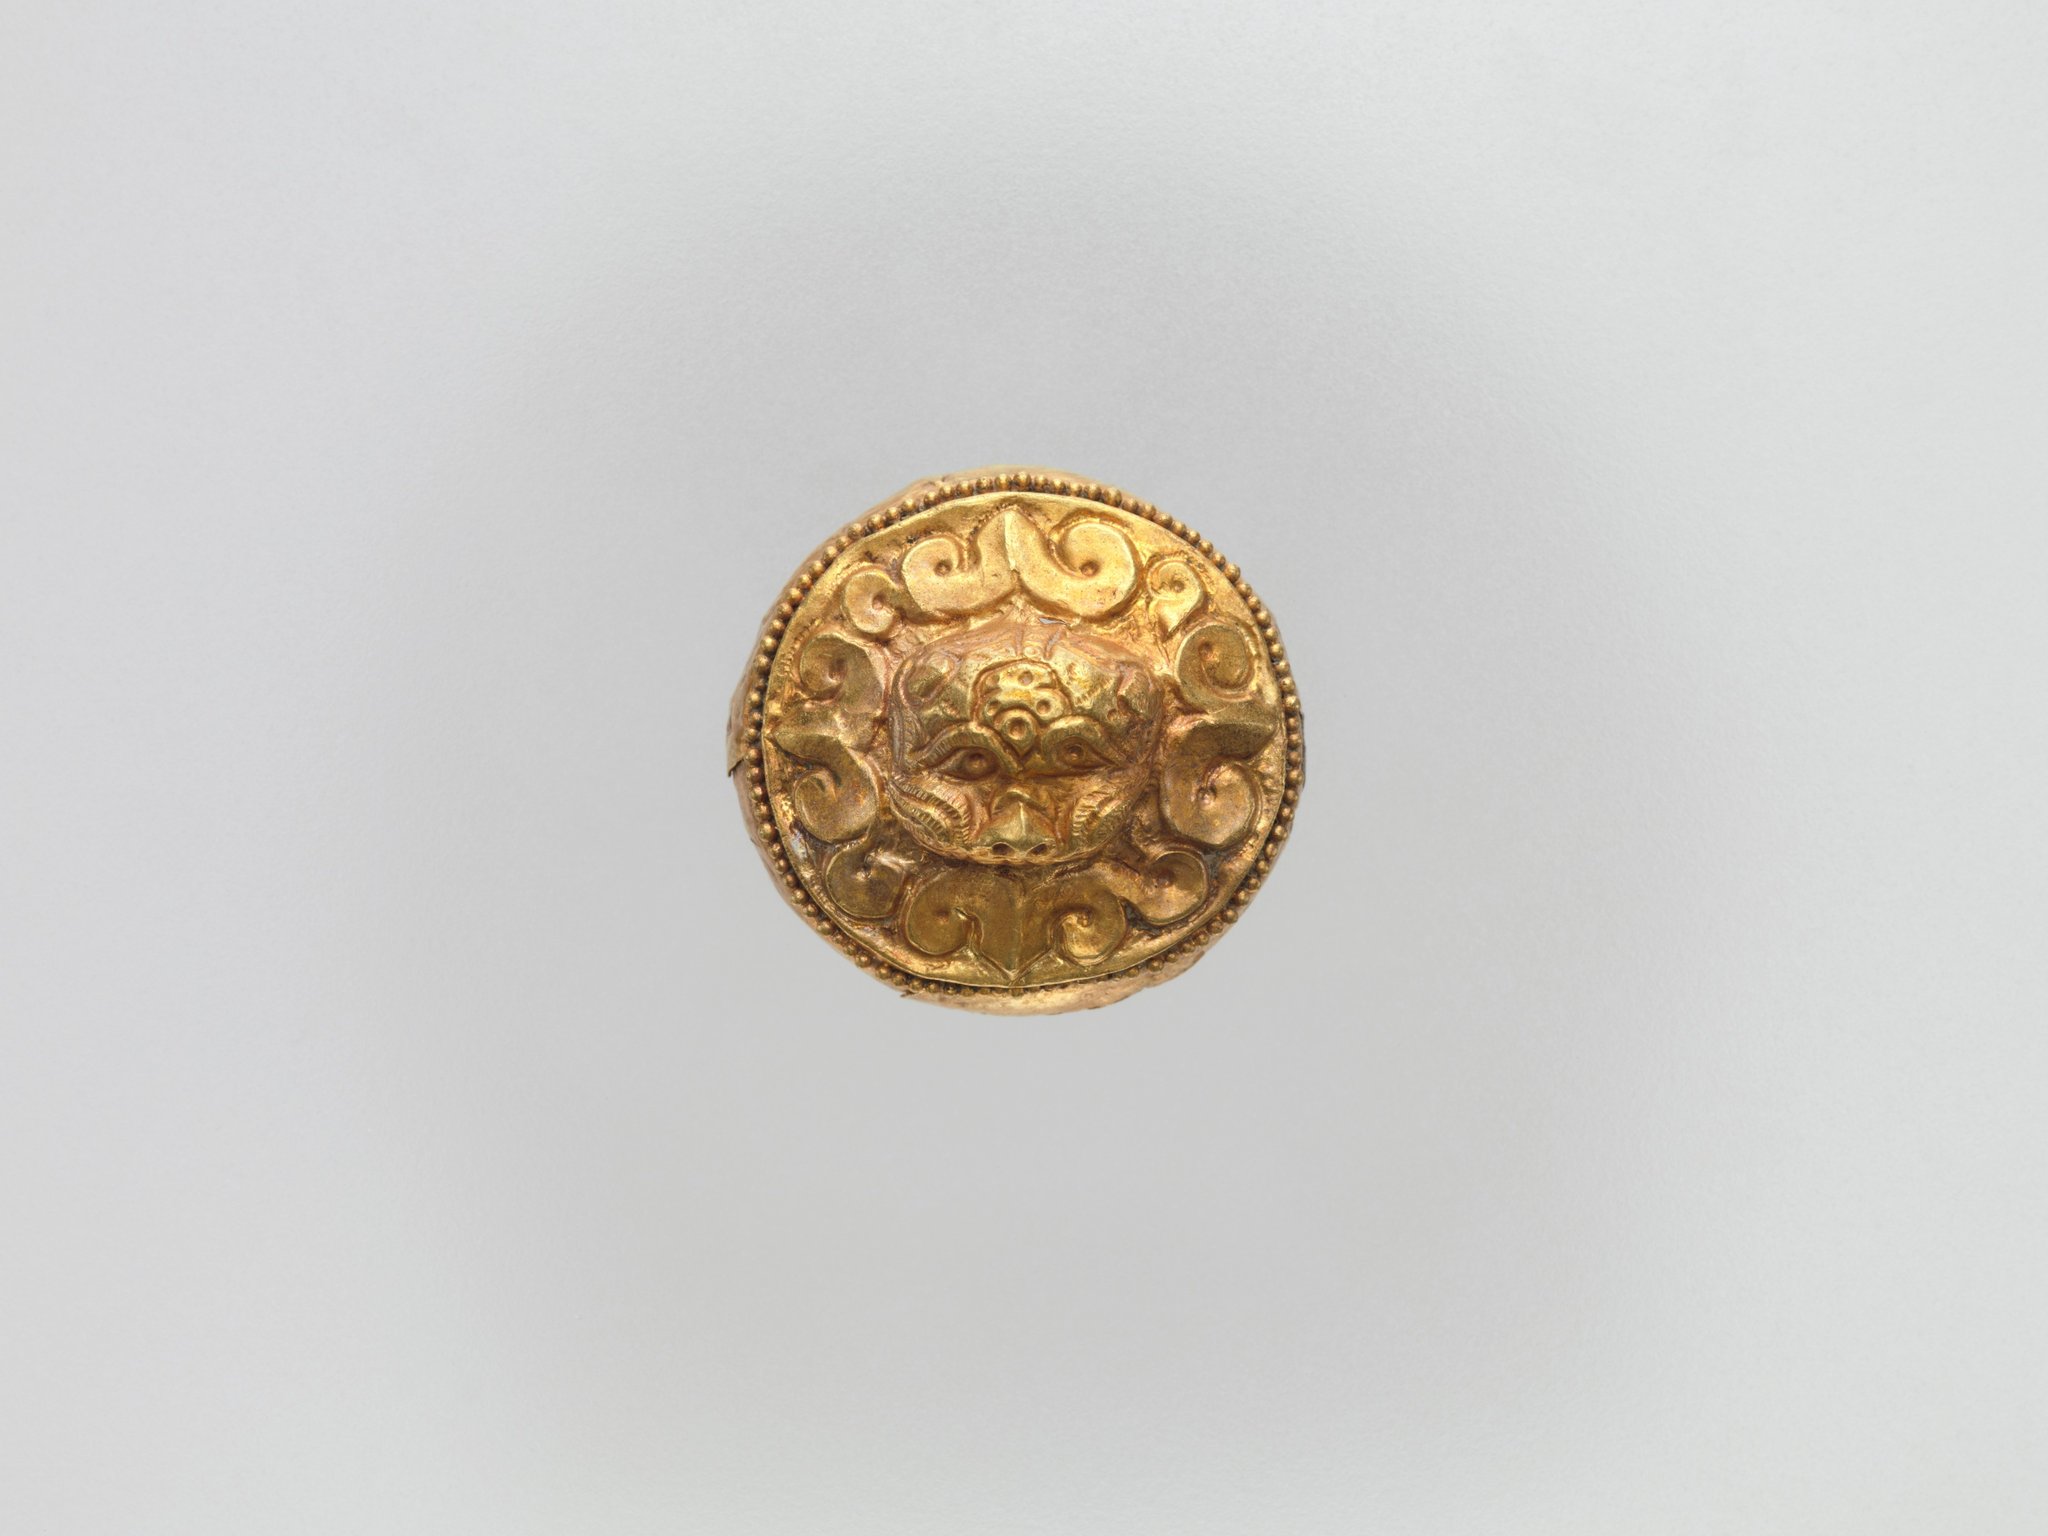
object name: plaque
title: Cap-Shaped Plaque with Lion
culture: chinese or central asian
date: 601-900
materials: gold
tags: lions